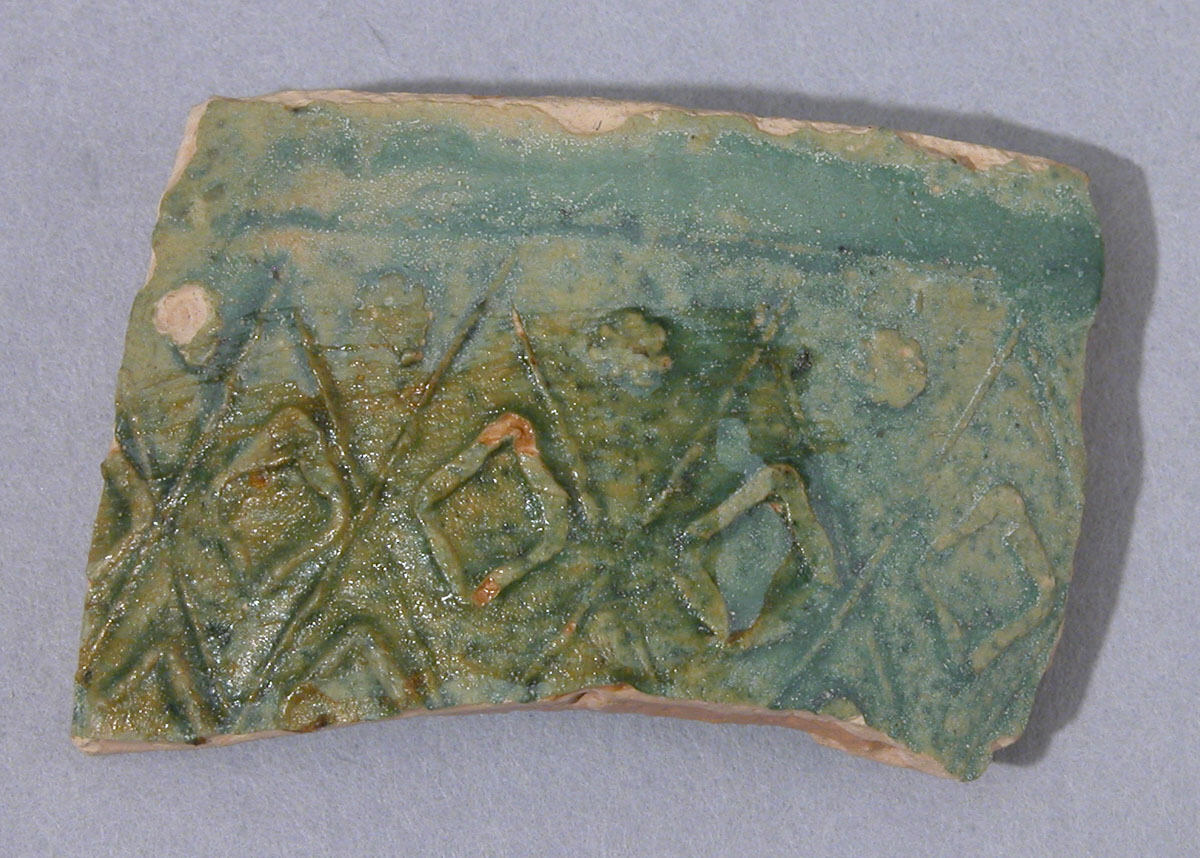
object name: fragment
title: Ceramic Fragment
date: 801-900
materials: earthenware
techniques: glazing, molding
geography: saudi arabia